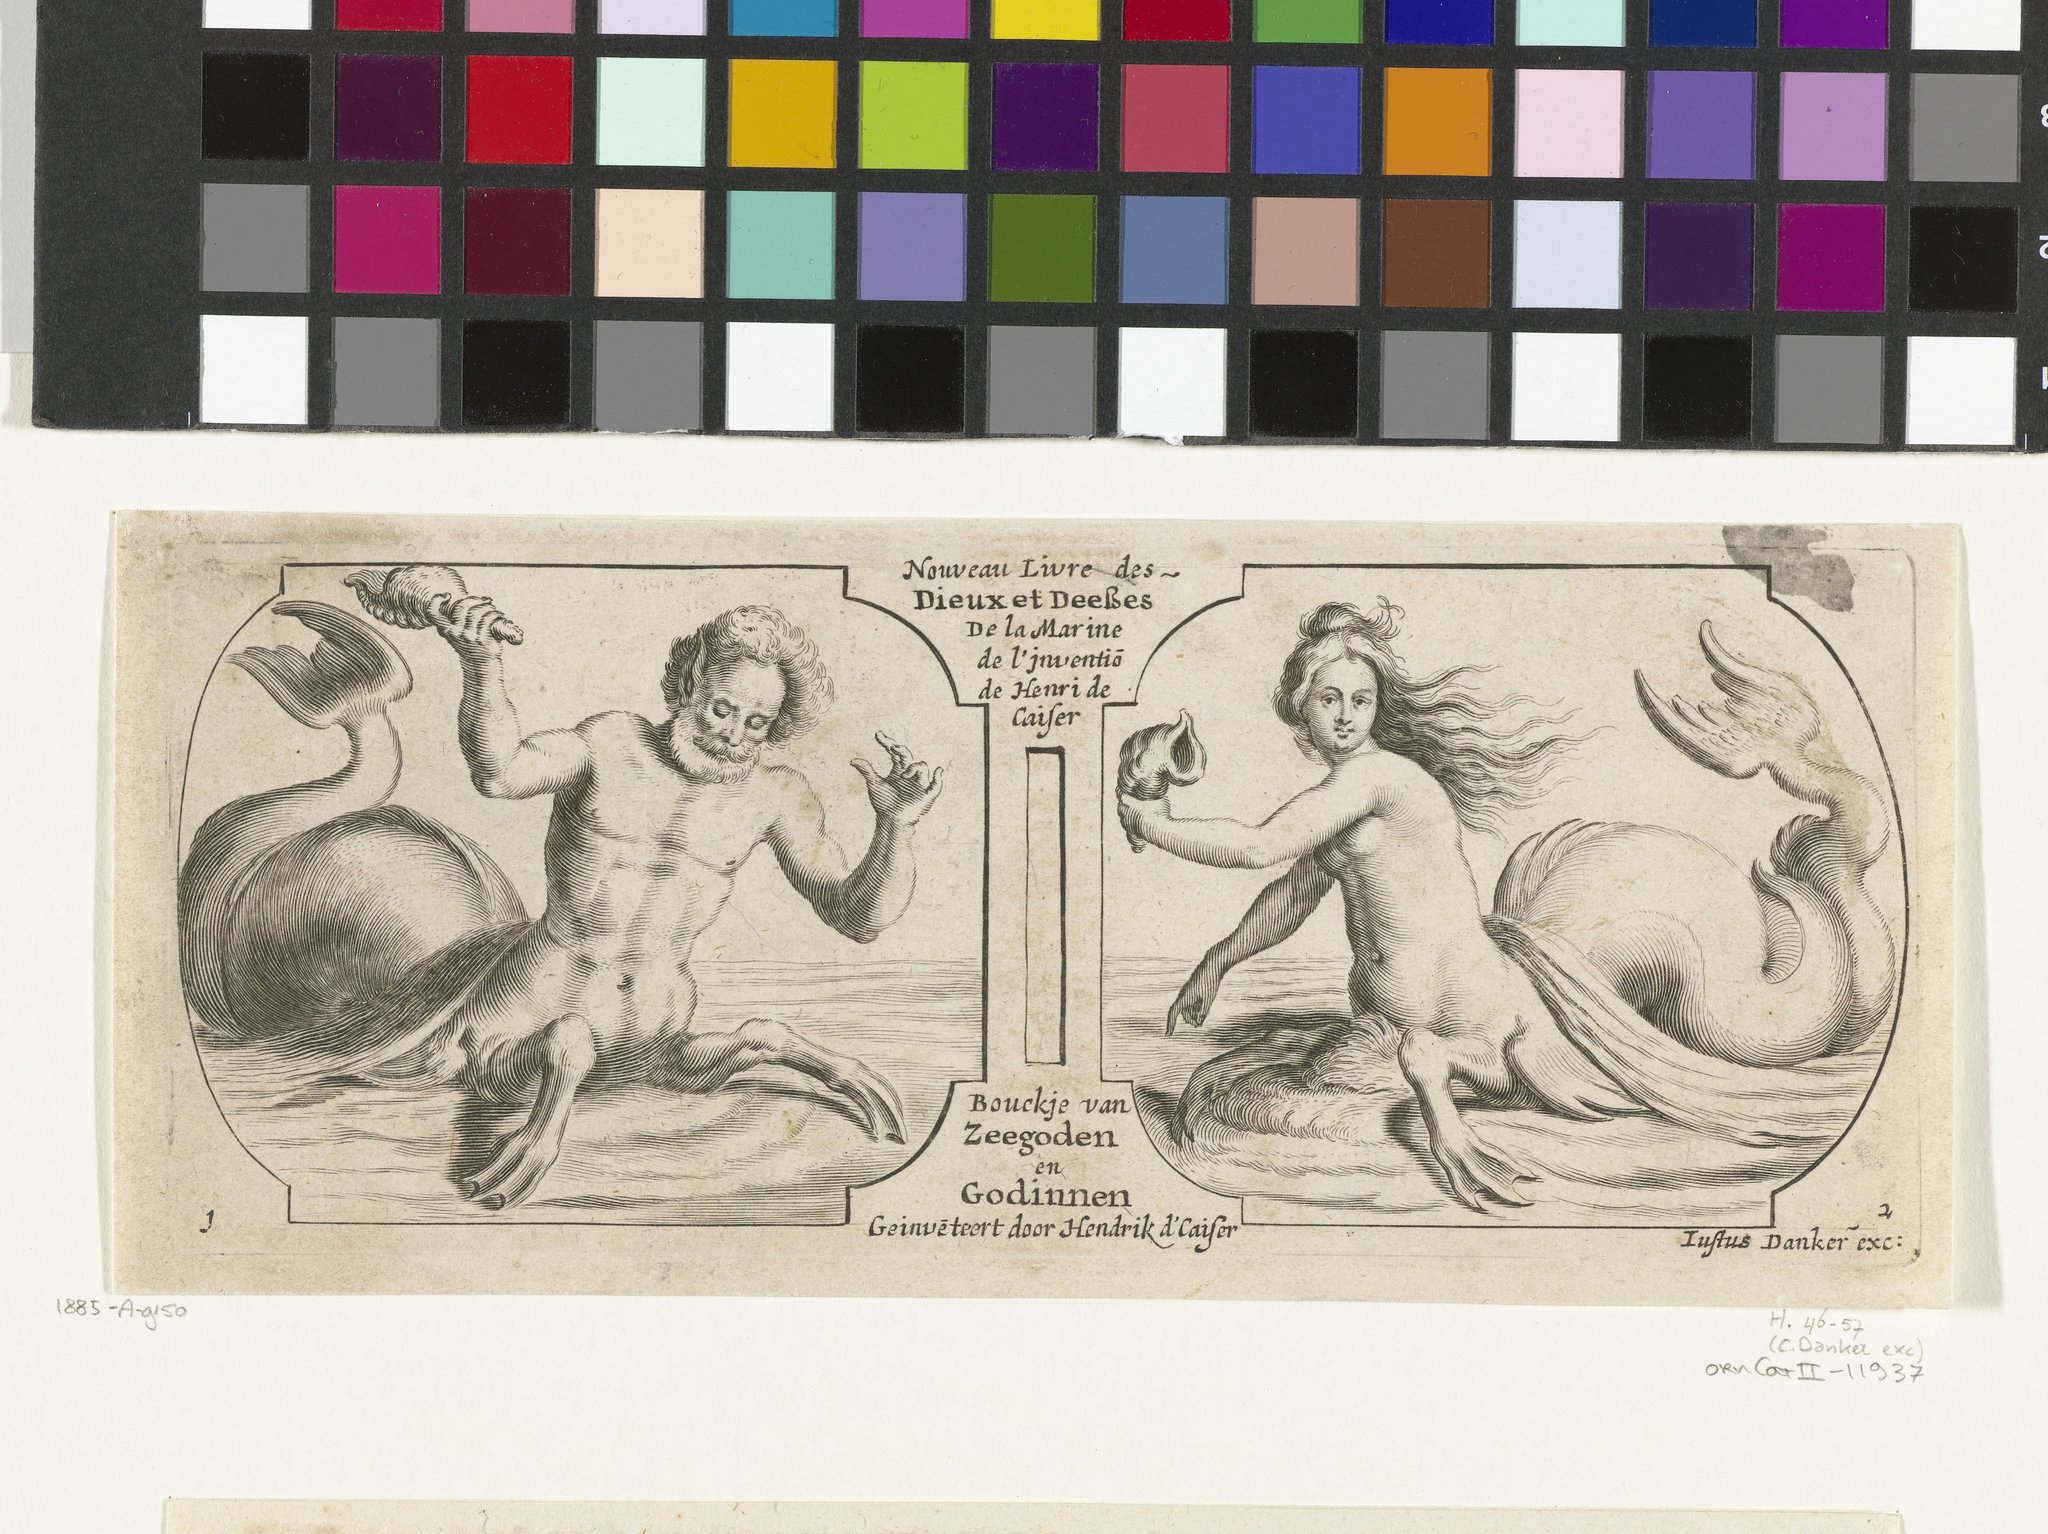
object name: ornament print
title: Twee compartimenten, in elk een triton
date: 1656-1701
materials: paper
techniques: engraving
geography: amsterdam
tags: triton(s)